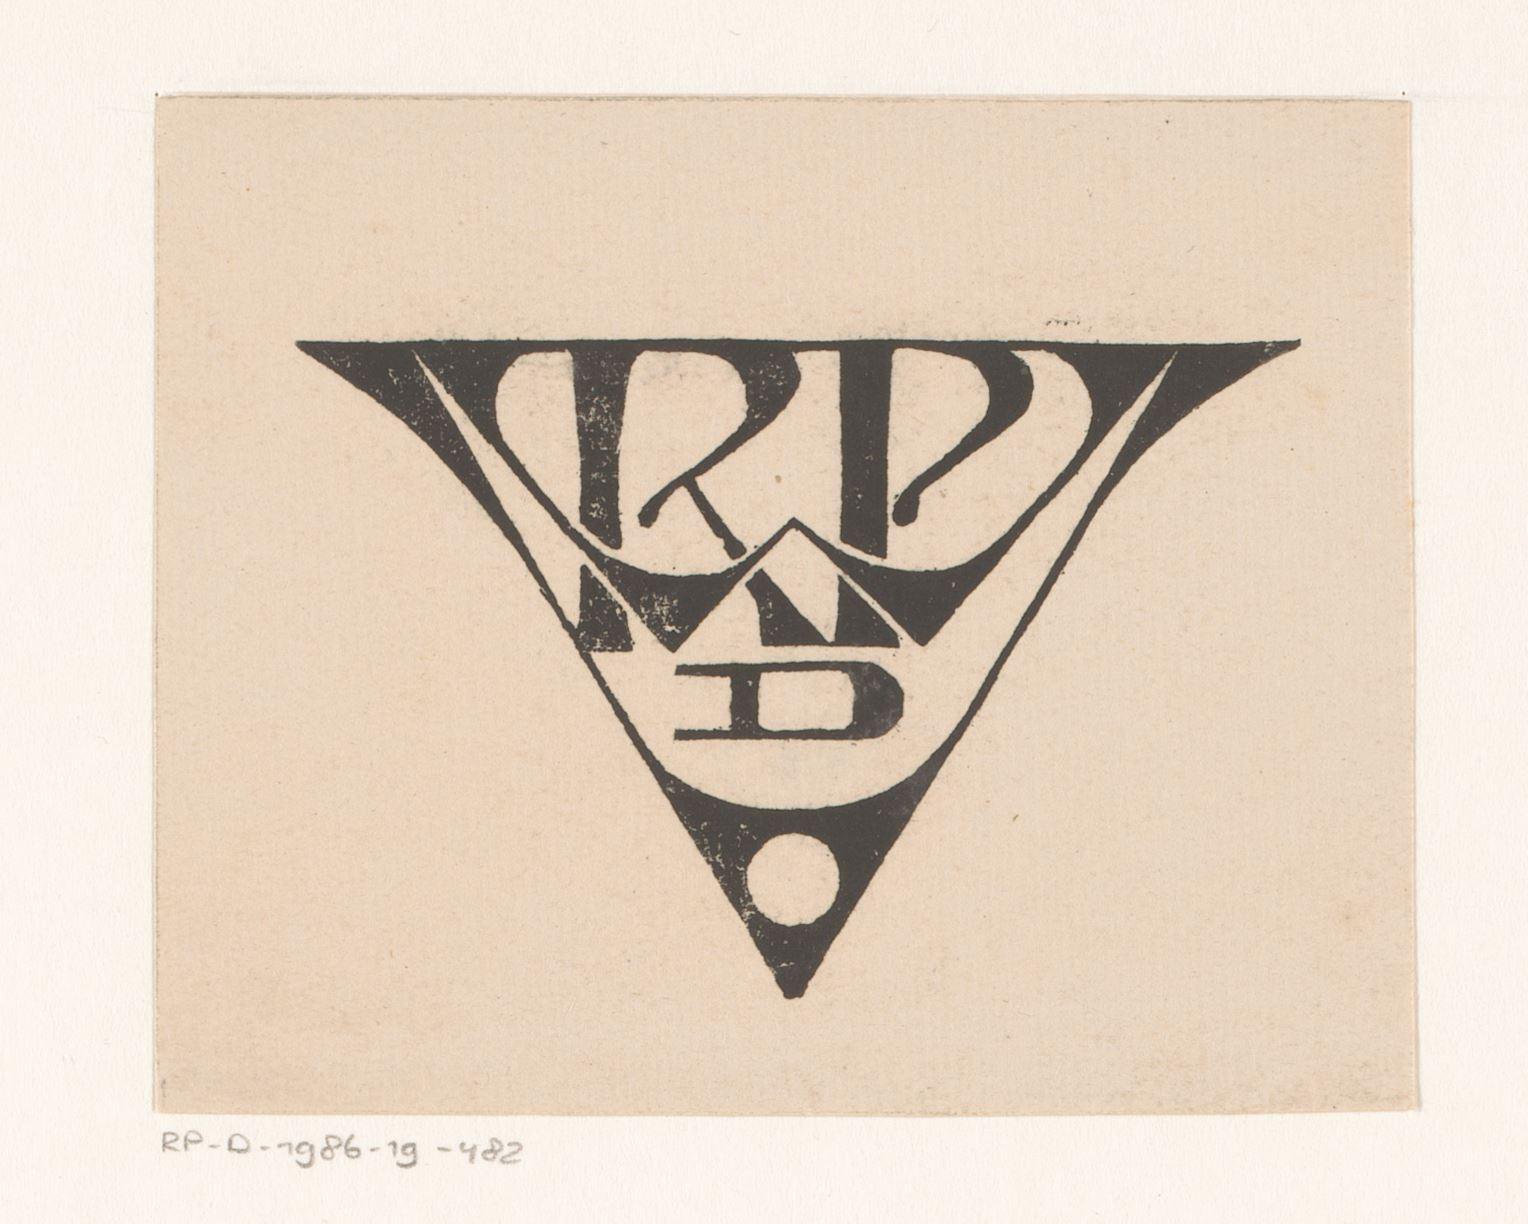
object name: photomechanical print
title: Vignet met monogram RWPdV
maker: reinier willem petrus de vries (1874-1953)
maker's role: draughtsman, print maker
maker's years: 1874-1953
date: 1884-1952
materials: paper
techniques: printing block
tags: magic mathematical figures; magic numbers, words, monograms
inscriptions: collector's mark: ‘R:MVS.’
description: Titelhoofd bedoeld voor het muziekstuk Wiegezang door de componist G. van Lammeren.